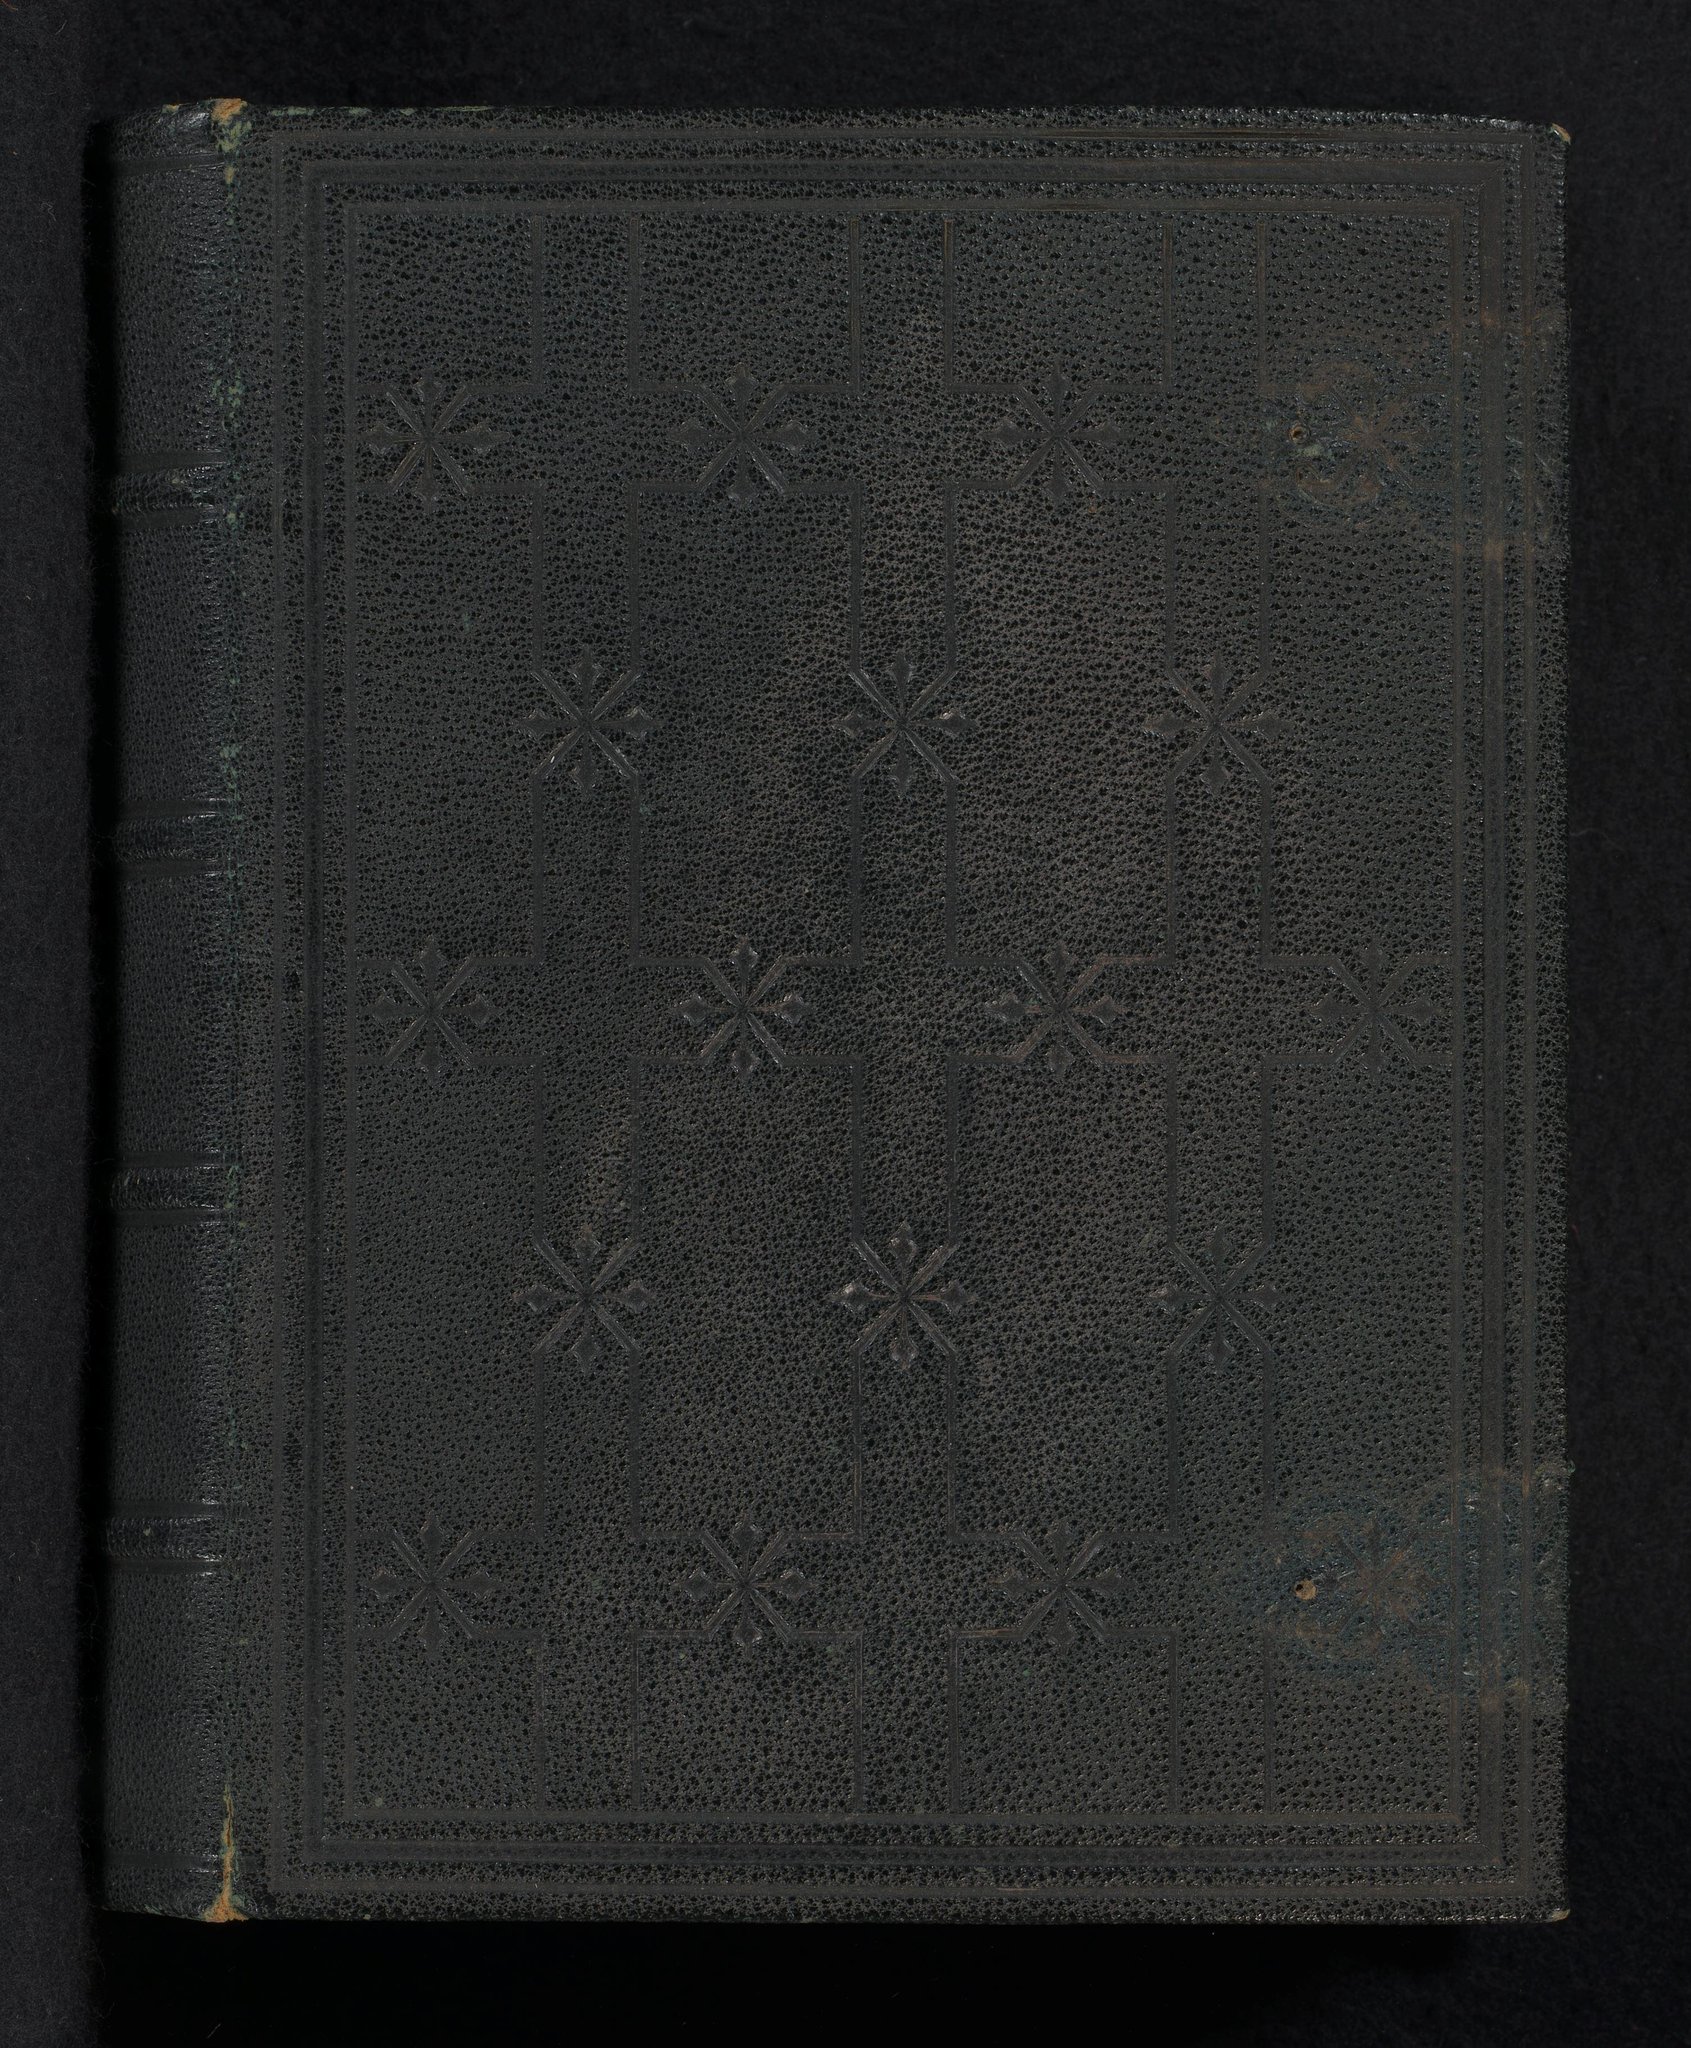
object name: photograph album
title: Fotoalbum met achttien portretten van mensen in Roemeense klederdrachten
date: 1860-1900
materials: cardboard, leather, paper, photographic support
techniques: albumen print, marbled paper, printing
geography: amsterdam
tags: historical persons - bb - woman, child, historical persons, folk costume, regional costume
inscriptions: collector's mark: ‘DIENST/ VERSPREIDE/ RIJKSKOLLEKTIES/ (...) A.693’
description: Fotoalbum met 27 bladen met in totaal 18 cartes-de-visite in passe-partouts. Iedere pagina bevat een met rode lijnen omkaderde rechthoekige passe-partout. Één van de negentien passe-partouts in het album is leeg. Het album is leeg aangekocht door verzamelaar L.J. Hartkamp en door hem gevuld met cartes-de-visite. Afgebeeld zijn portretten van mannen, vrouwen en kinderen in Roemeense klederdracht. De foto's zijn gemaakt door de fotografen F. Duschek (2) en Carol Popp de Szathmari (16). Op de rug van het album is de naam Antoine Maitre gepreegd.